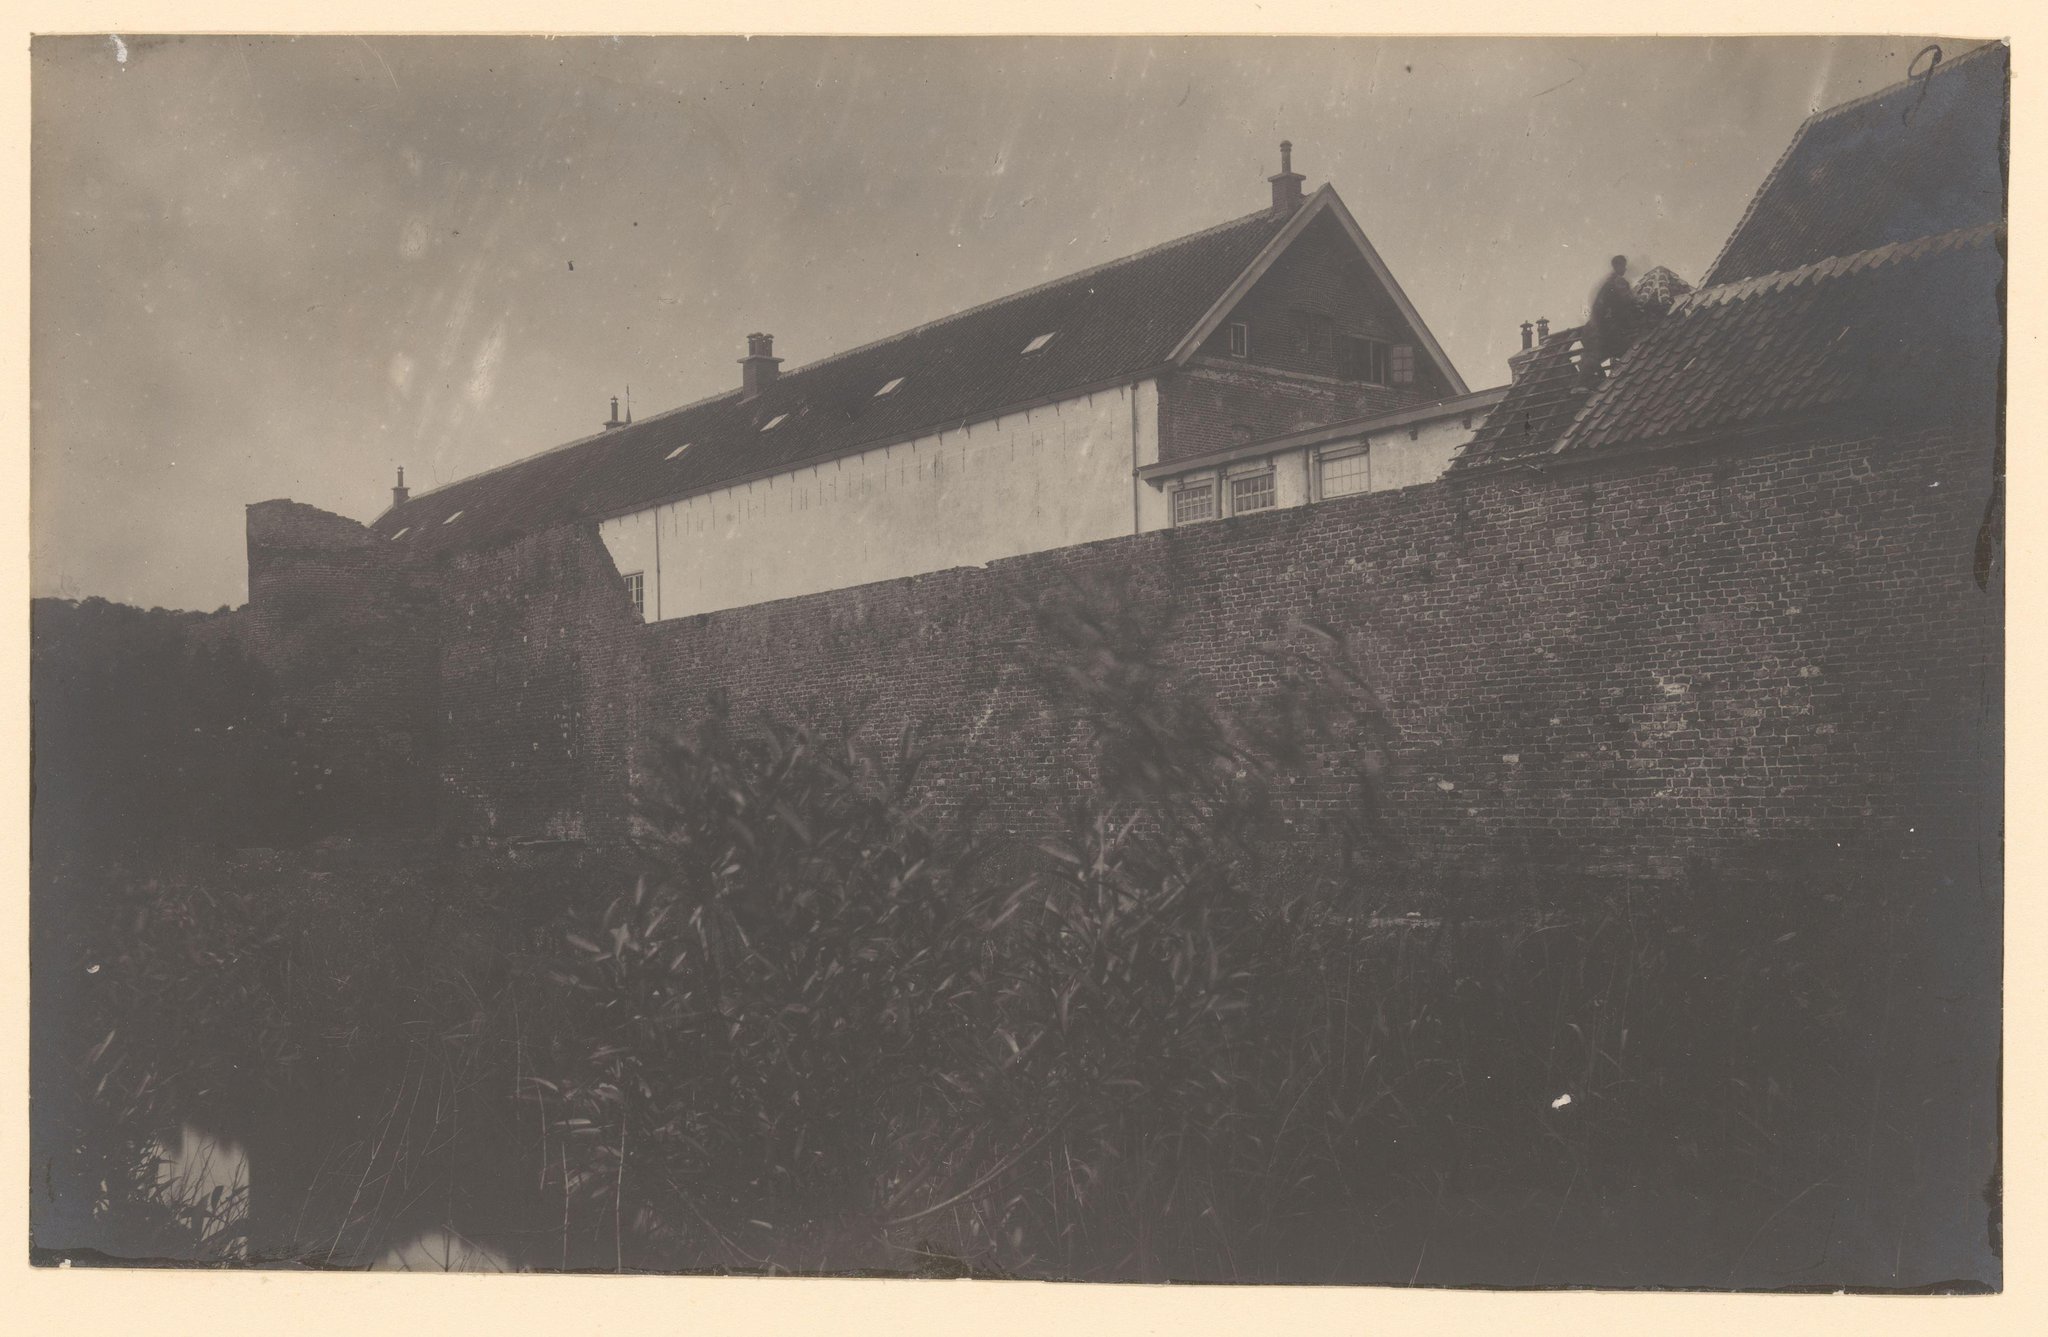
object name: photograph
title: Gedeelte van de stadsmuur van Harderwijk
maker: anoniem (monumentenzorg)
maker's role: fotograaf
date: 1900-1920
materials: cardboard, photographic support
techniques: gelatin silver print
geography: harderwijk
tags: city-walls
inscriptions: annotation: ‘Stadswalmuur/ Harderwijk’, annotation: ‘g/ Harderwijk’